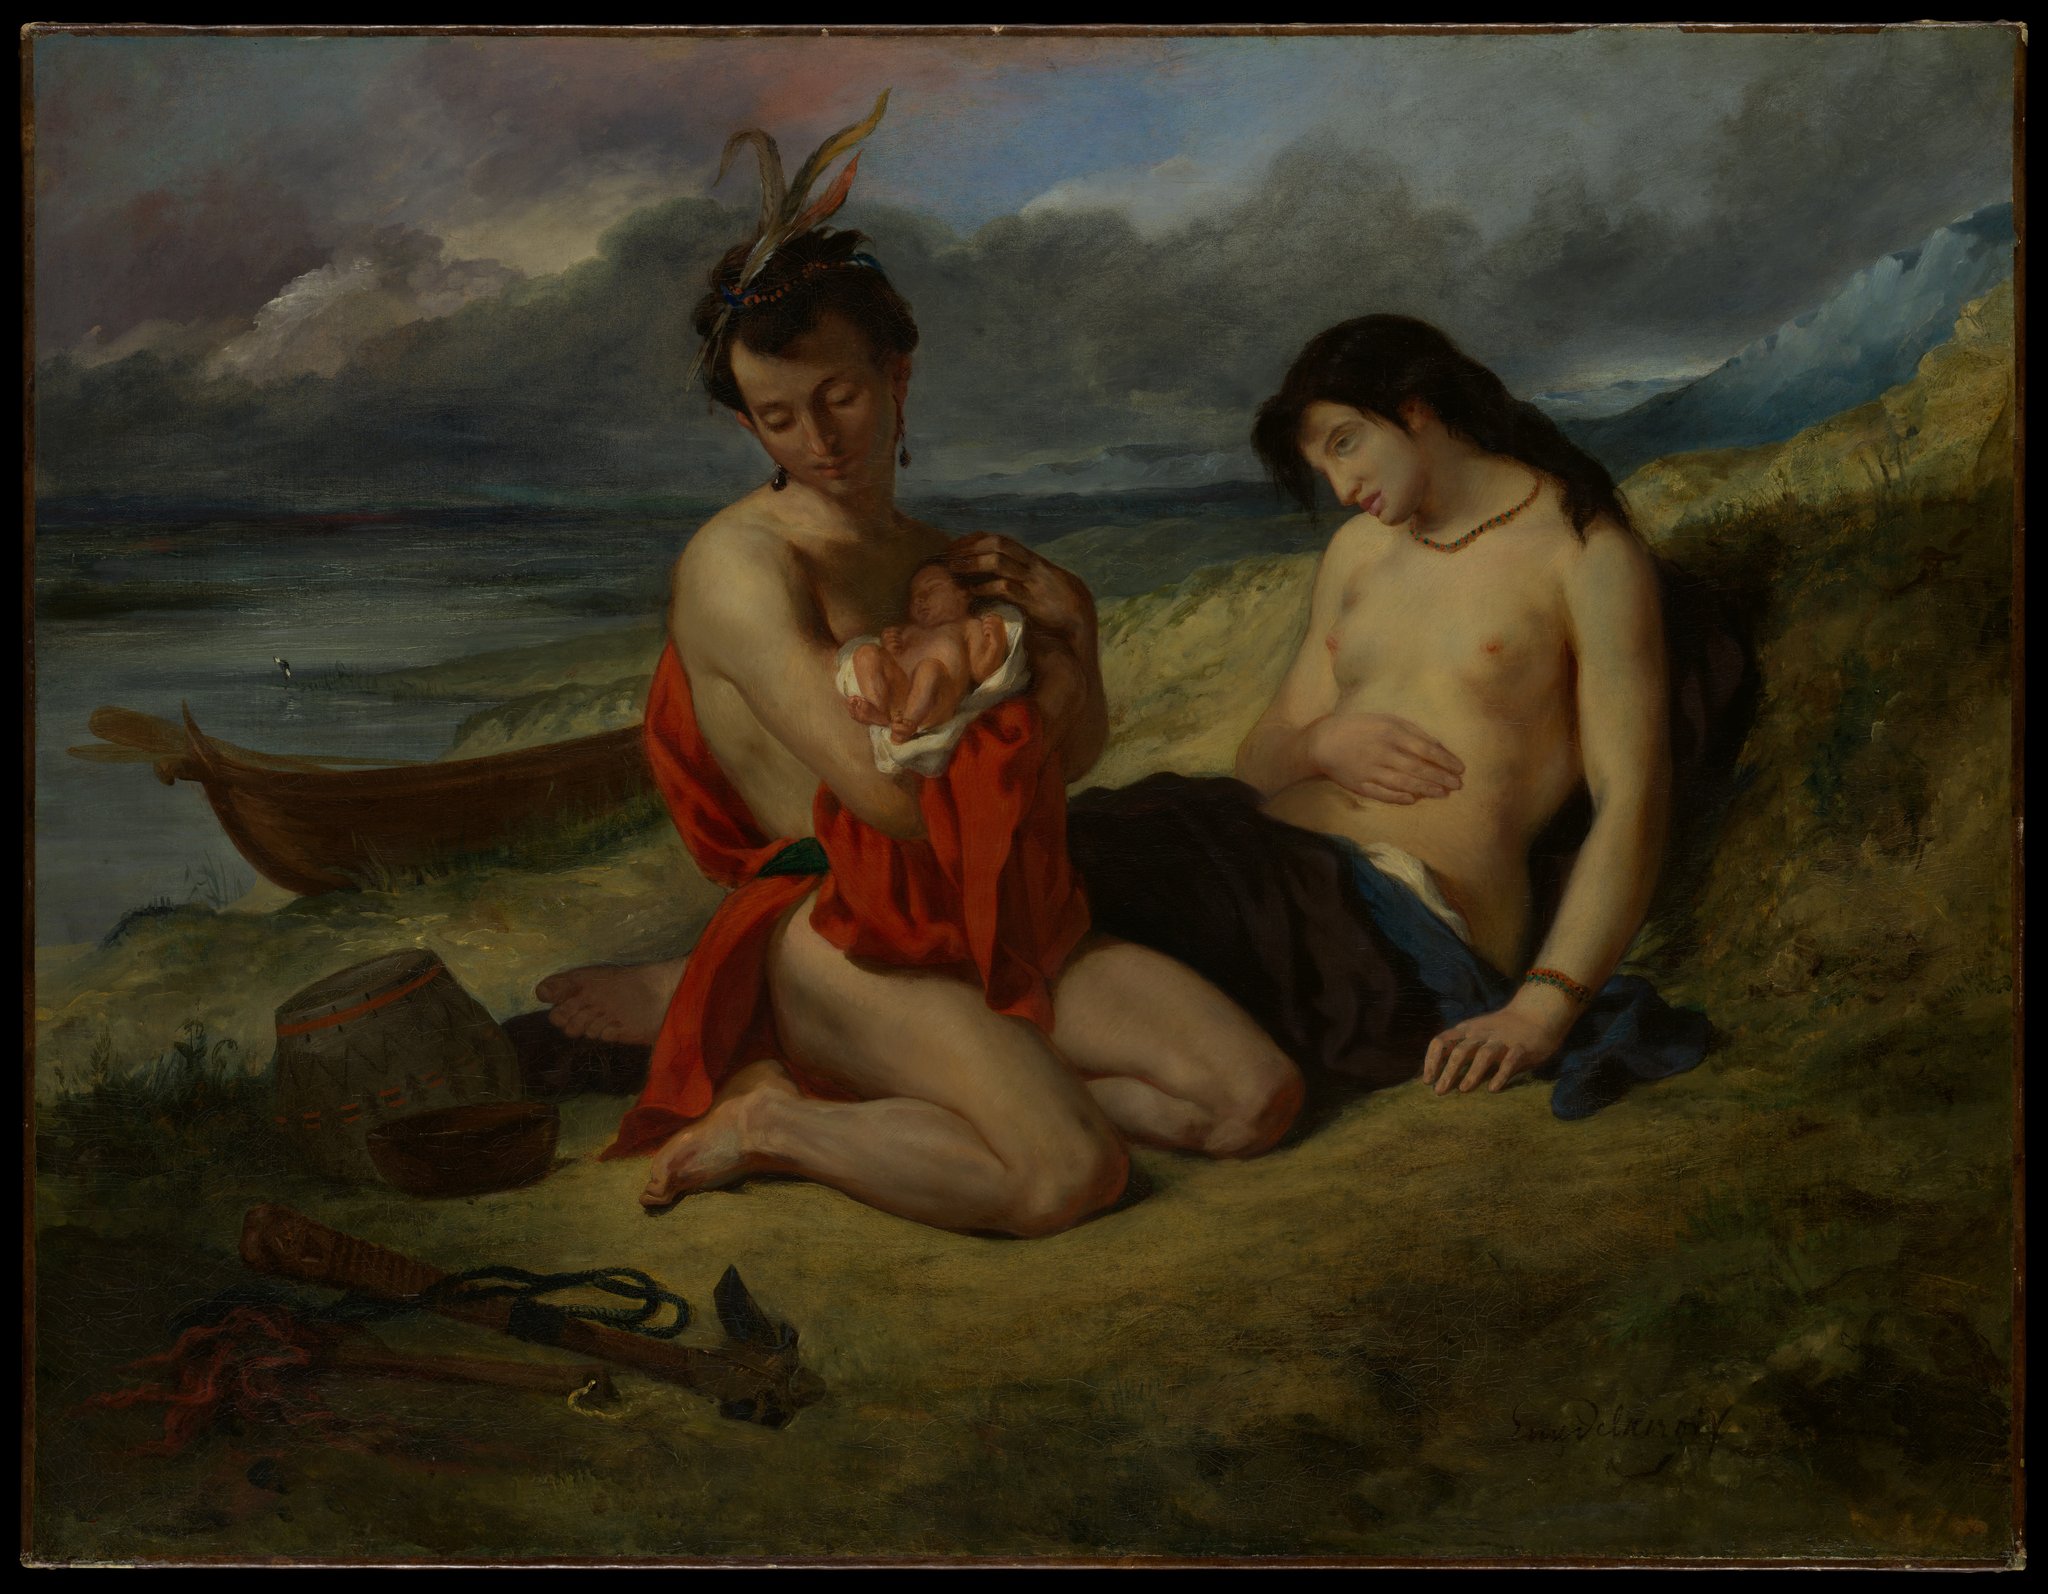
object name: painting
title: The Natchez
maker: eugène delacroix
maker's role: artist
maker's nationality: french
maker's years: 1798-1863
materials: canvas, oil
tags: infants,fathers,mothers,family